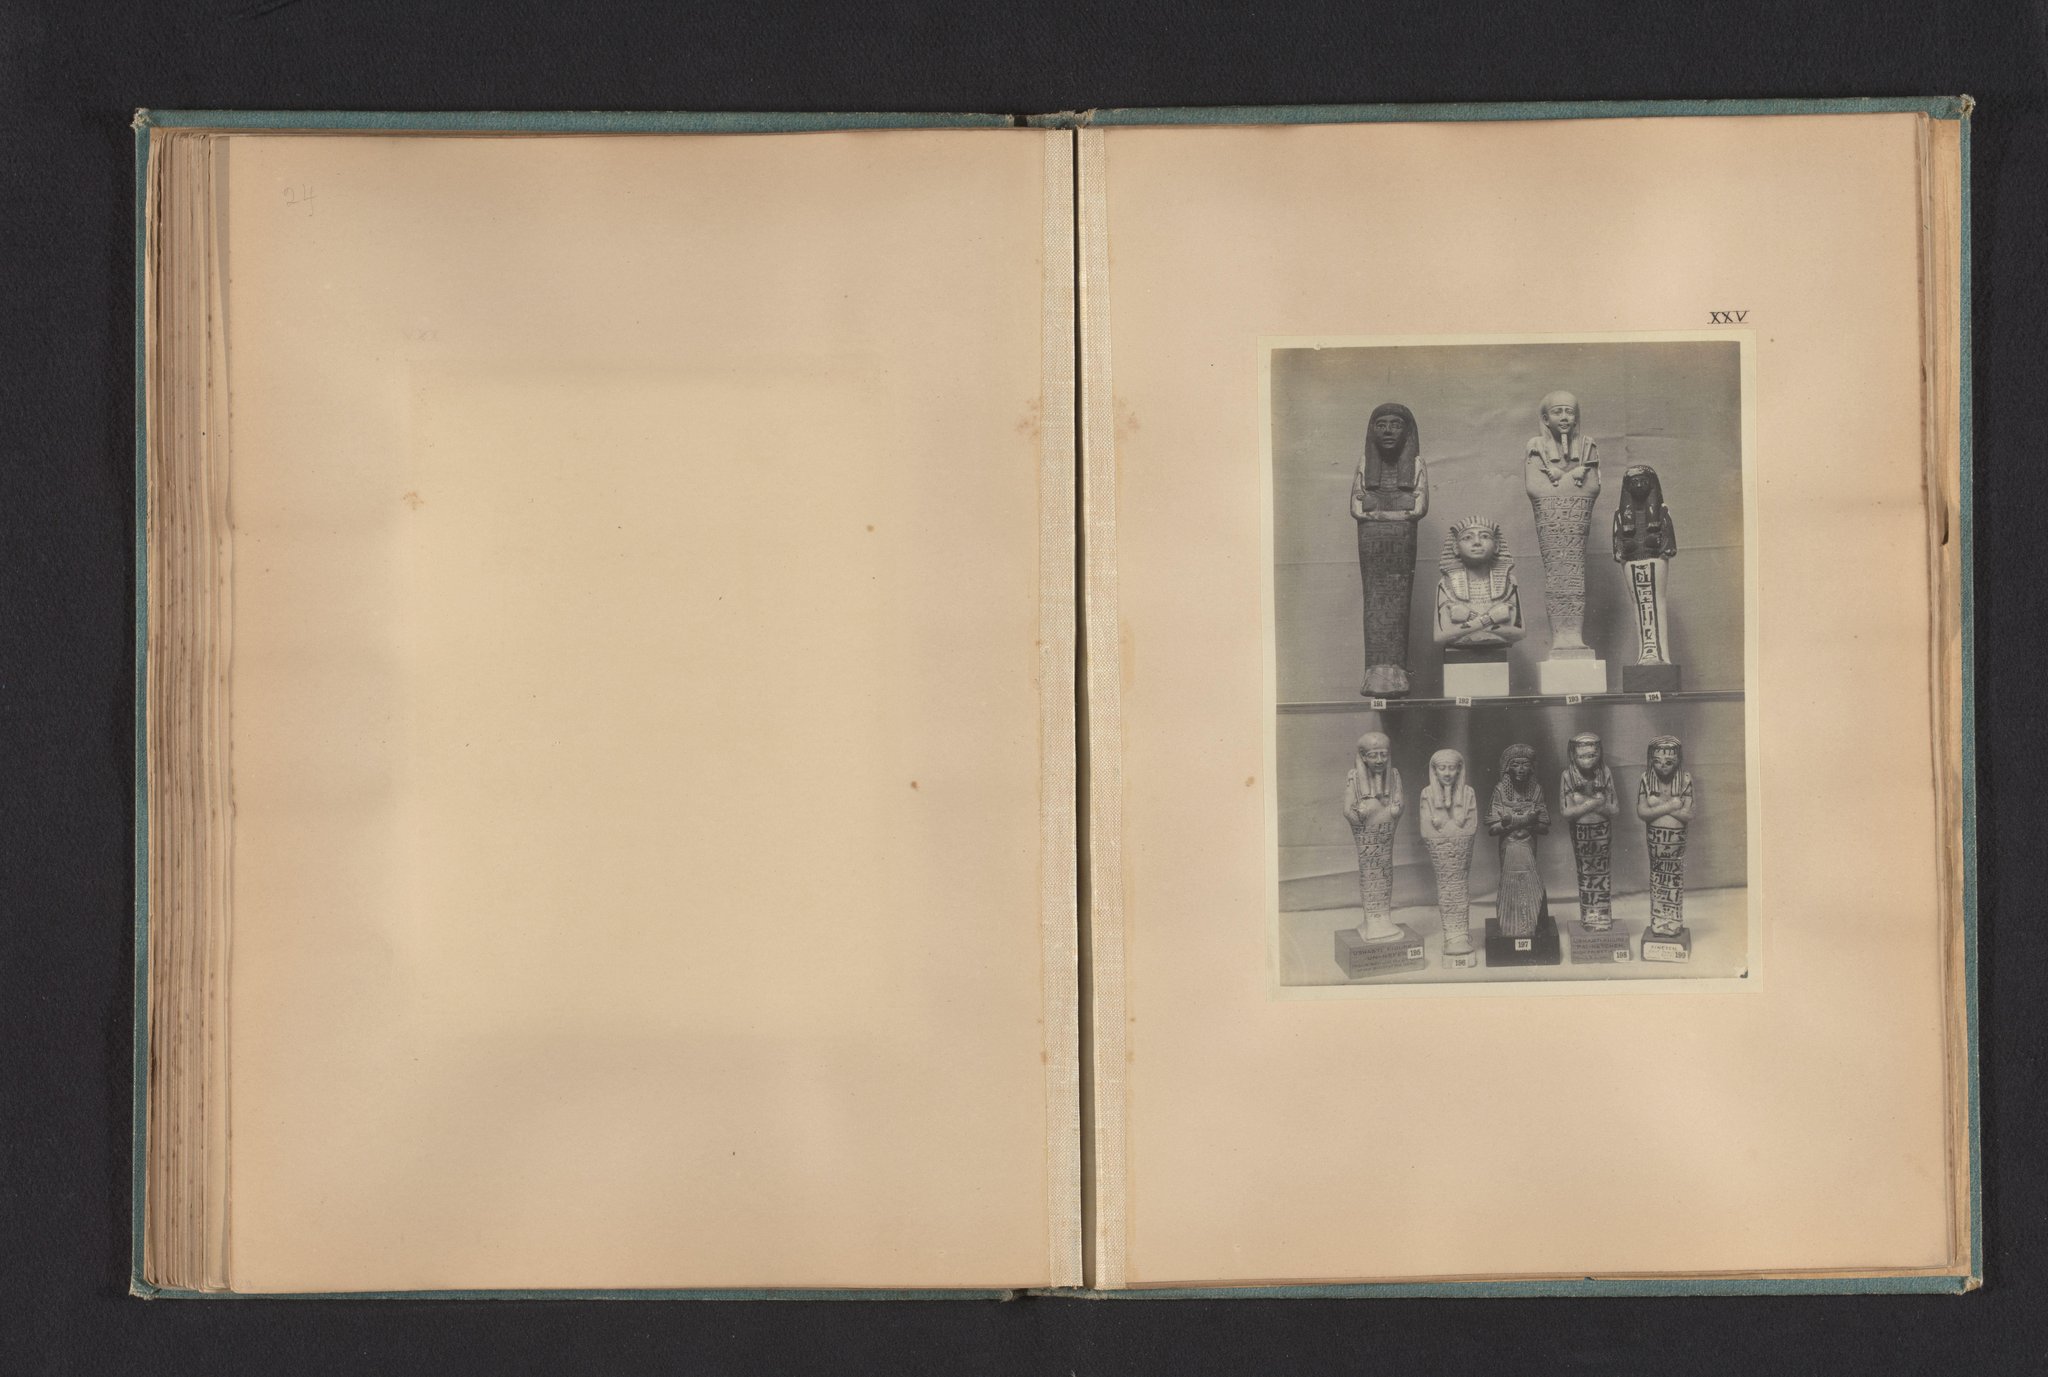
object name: page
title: Negen Egyptische sculpturen, allen ushabti's of delen van een ushabti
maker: Anonymous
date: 1890-1895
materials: photographic support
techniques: gelatin silver print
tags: adult woman, sculpture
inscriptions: number: ‘XXV’